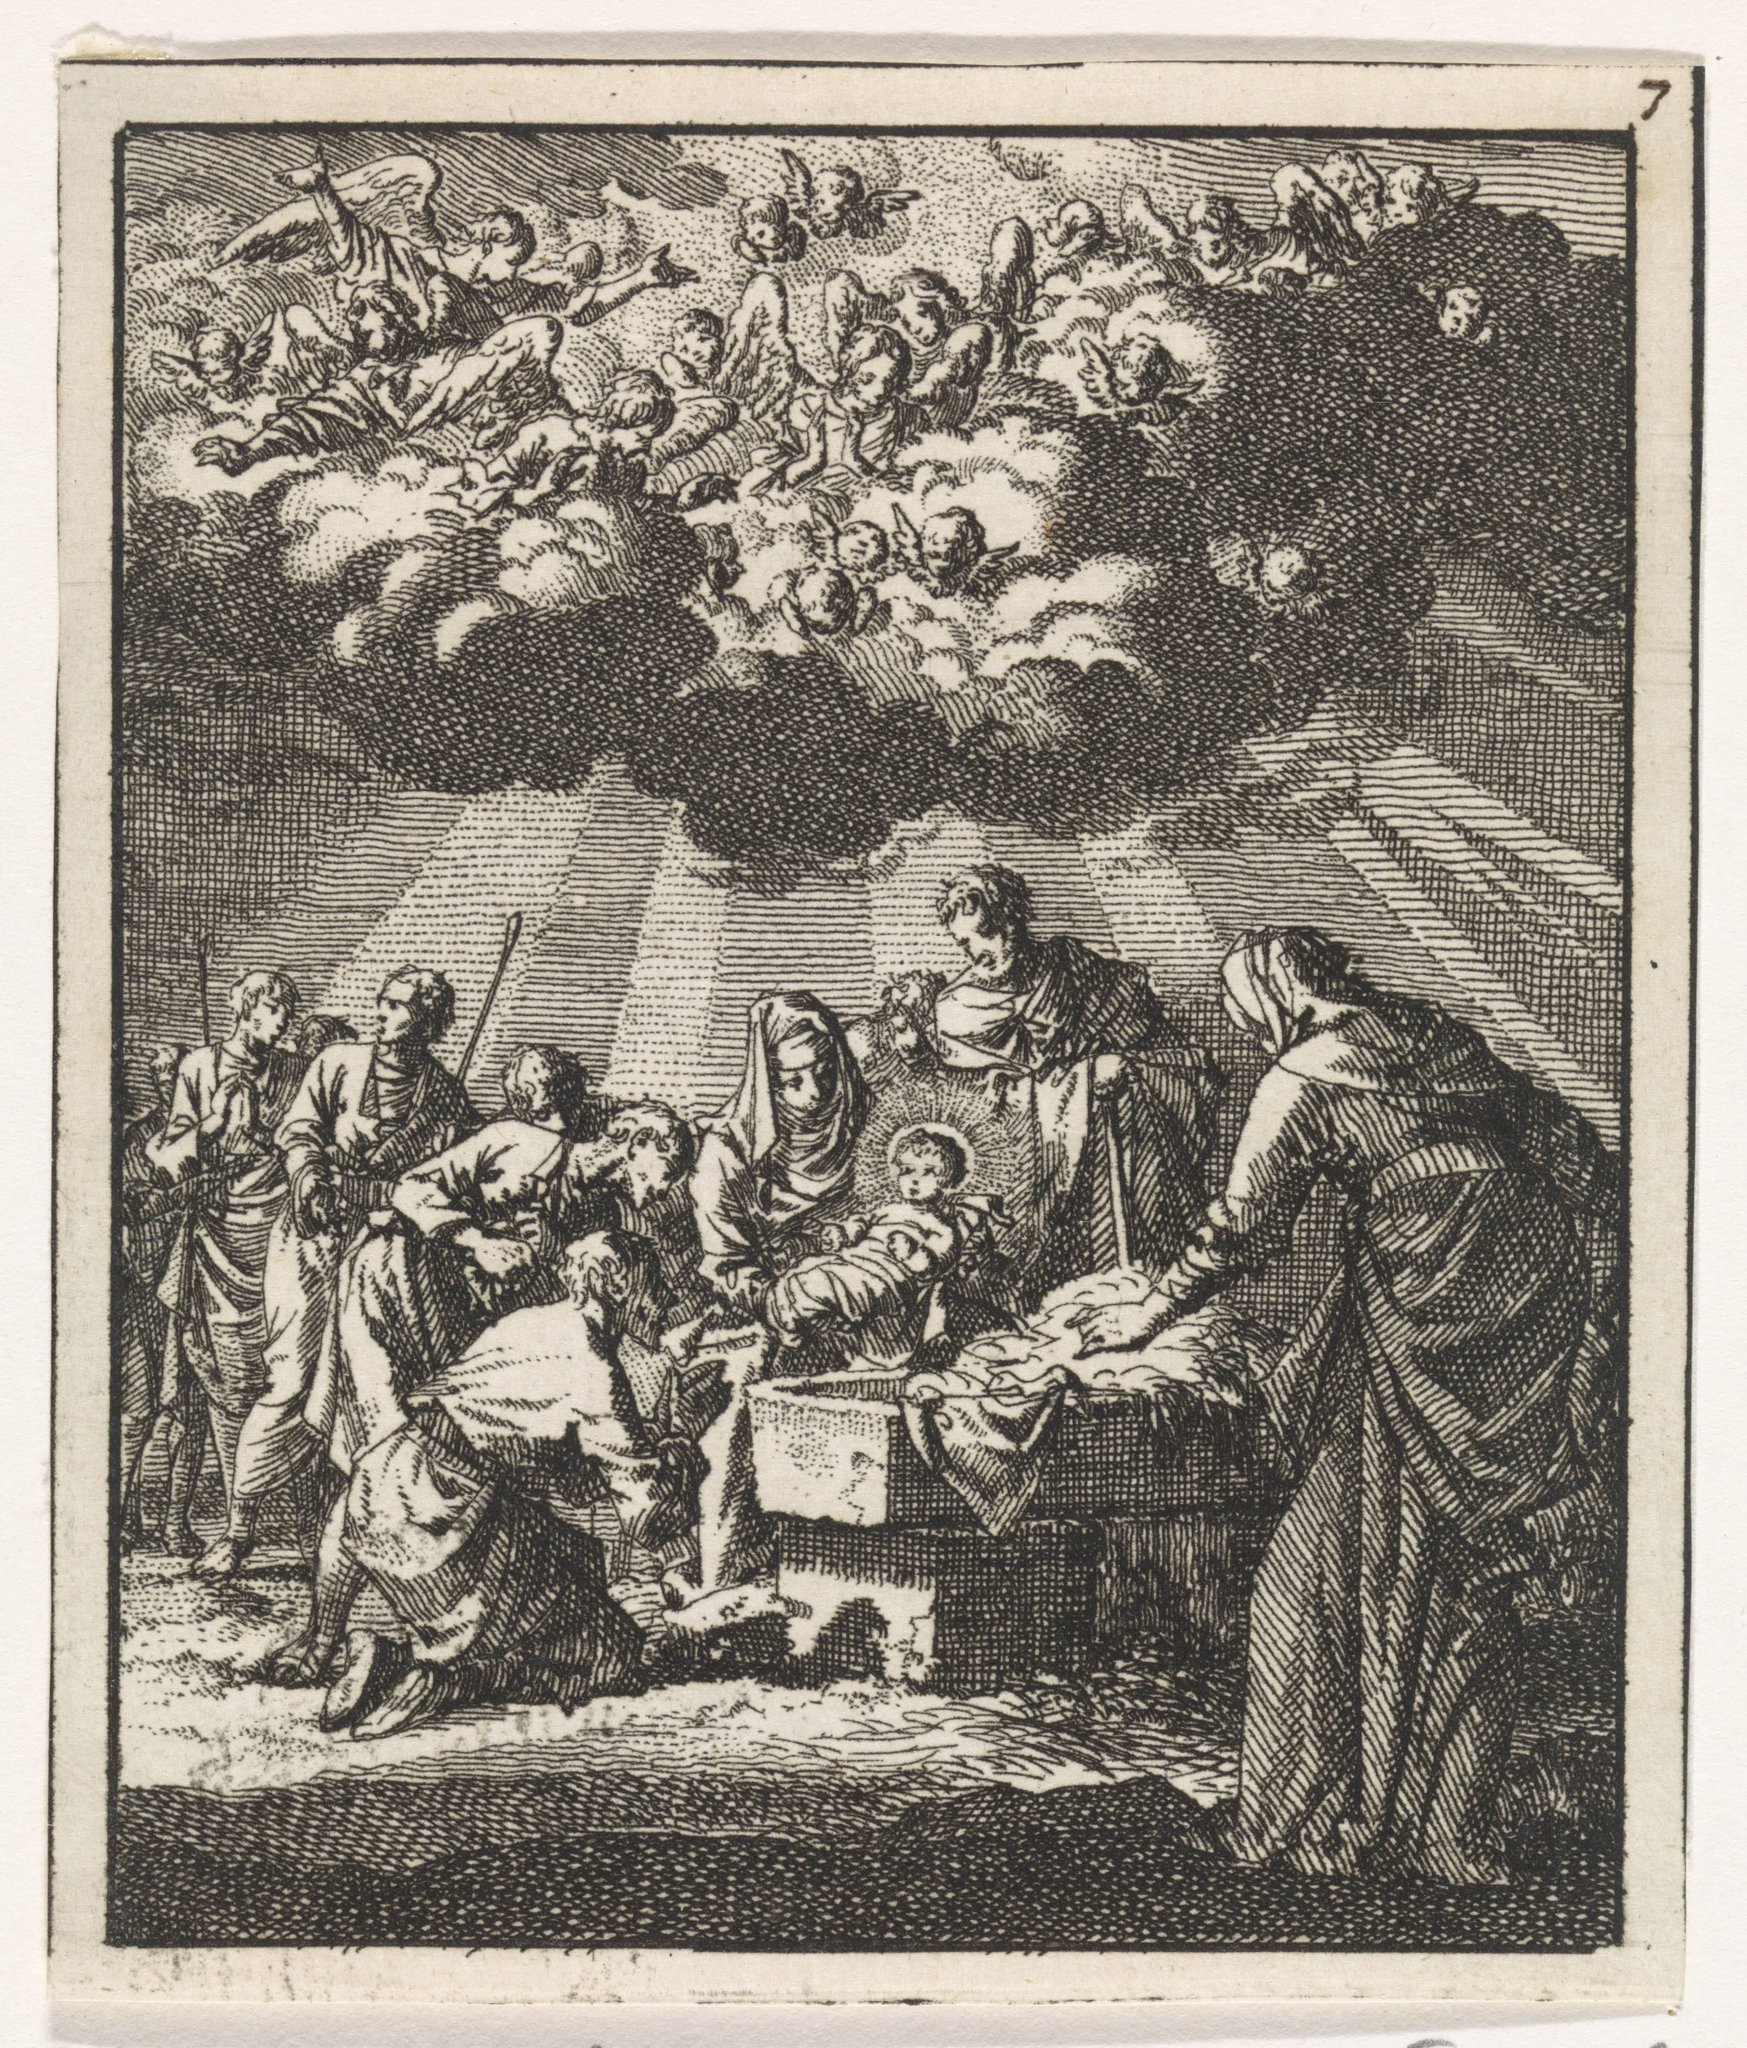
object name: print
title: Aanbidding door de herders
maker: jan luyken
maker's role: draughtsman, print maker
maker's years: 1649-1712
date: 1704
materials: paper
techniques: etching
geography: amsterdam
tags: adoration of the christ-child by the shepherds; mary and joseph present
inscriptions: collector's mark: Lugt 2228, number: ‘7’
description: Proefdruk van illustratie uit: Luyken, Jan. De zedelyke en stichtelyke gezangen. Amsterdam: Wed. Pieter Arentsz (II) en Cornelis van der Sys, 1704, p. 35.